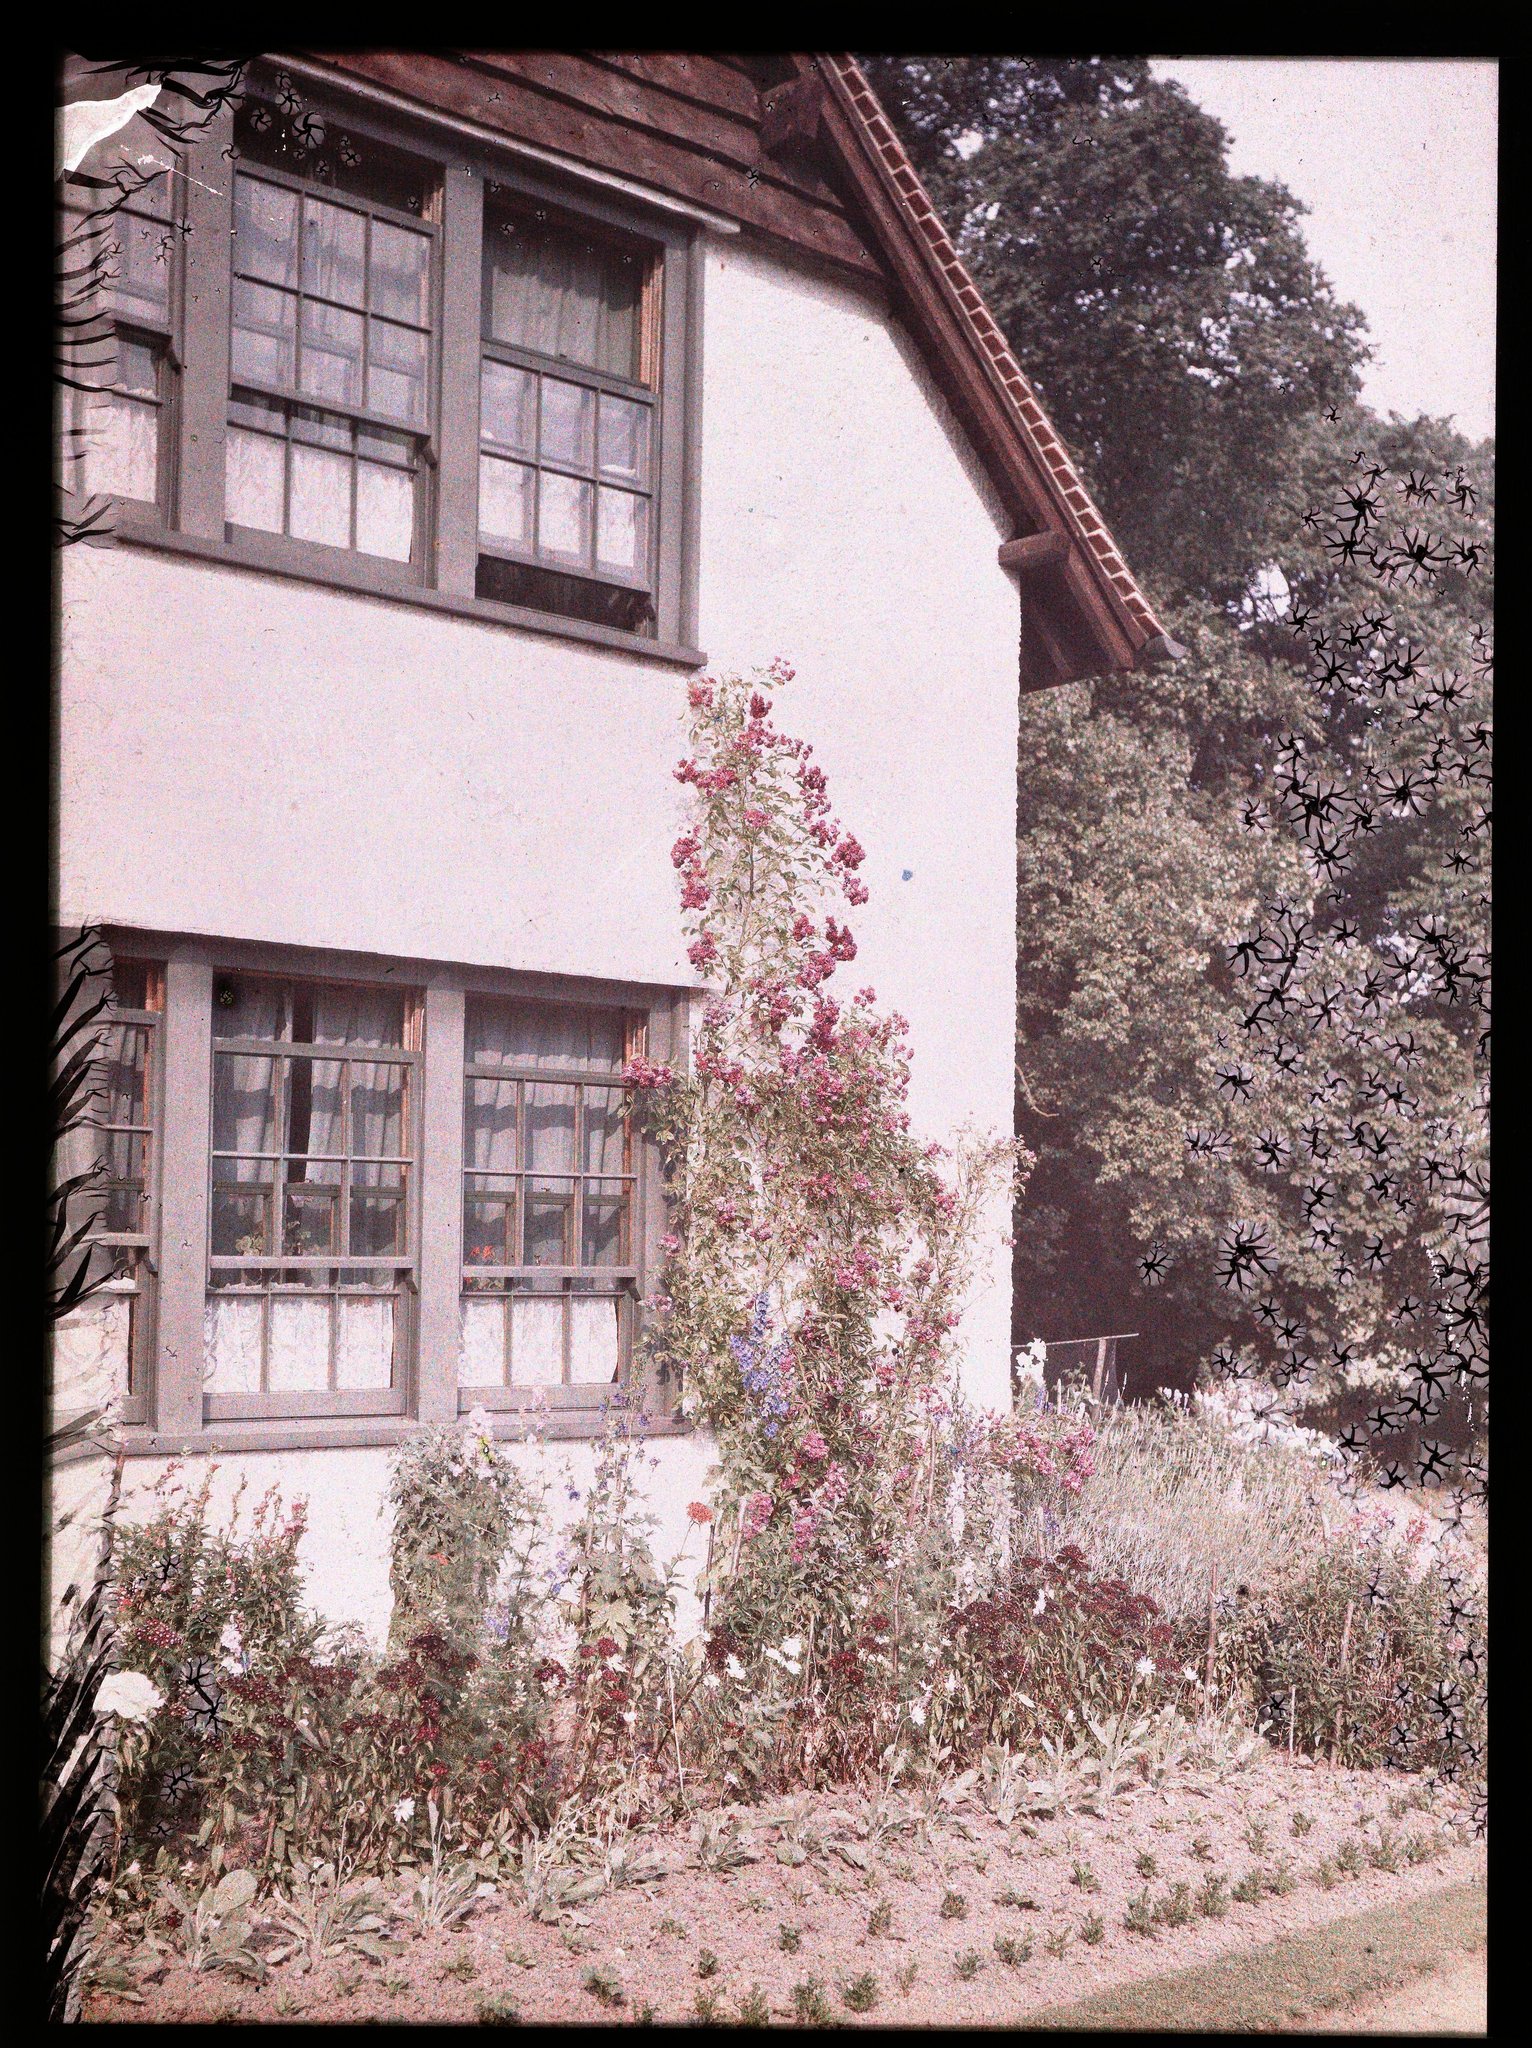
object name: photograph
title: Klimplant tegen de muur van een huis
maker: adolphe burdet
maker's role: fotograaf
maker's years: 1860-1940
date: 1907-1930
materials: glass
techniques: autochrome process, slide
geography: netherlands